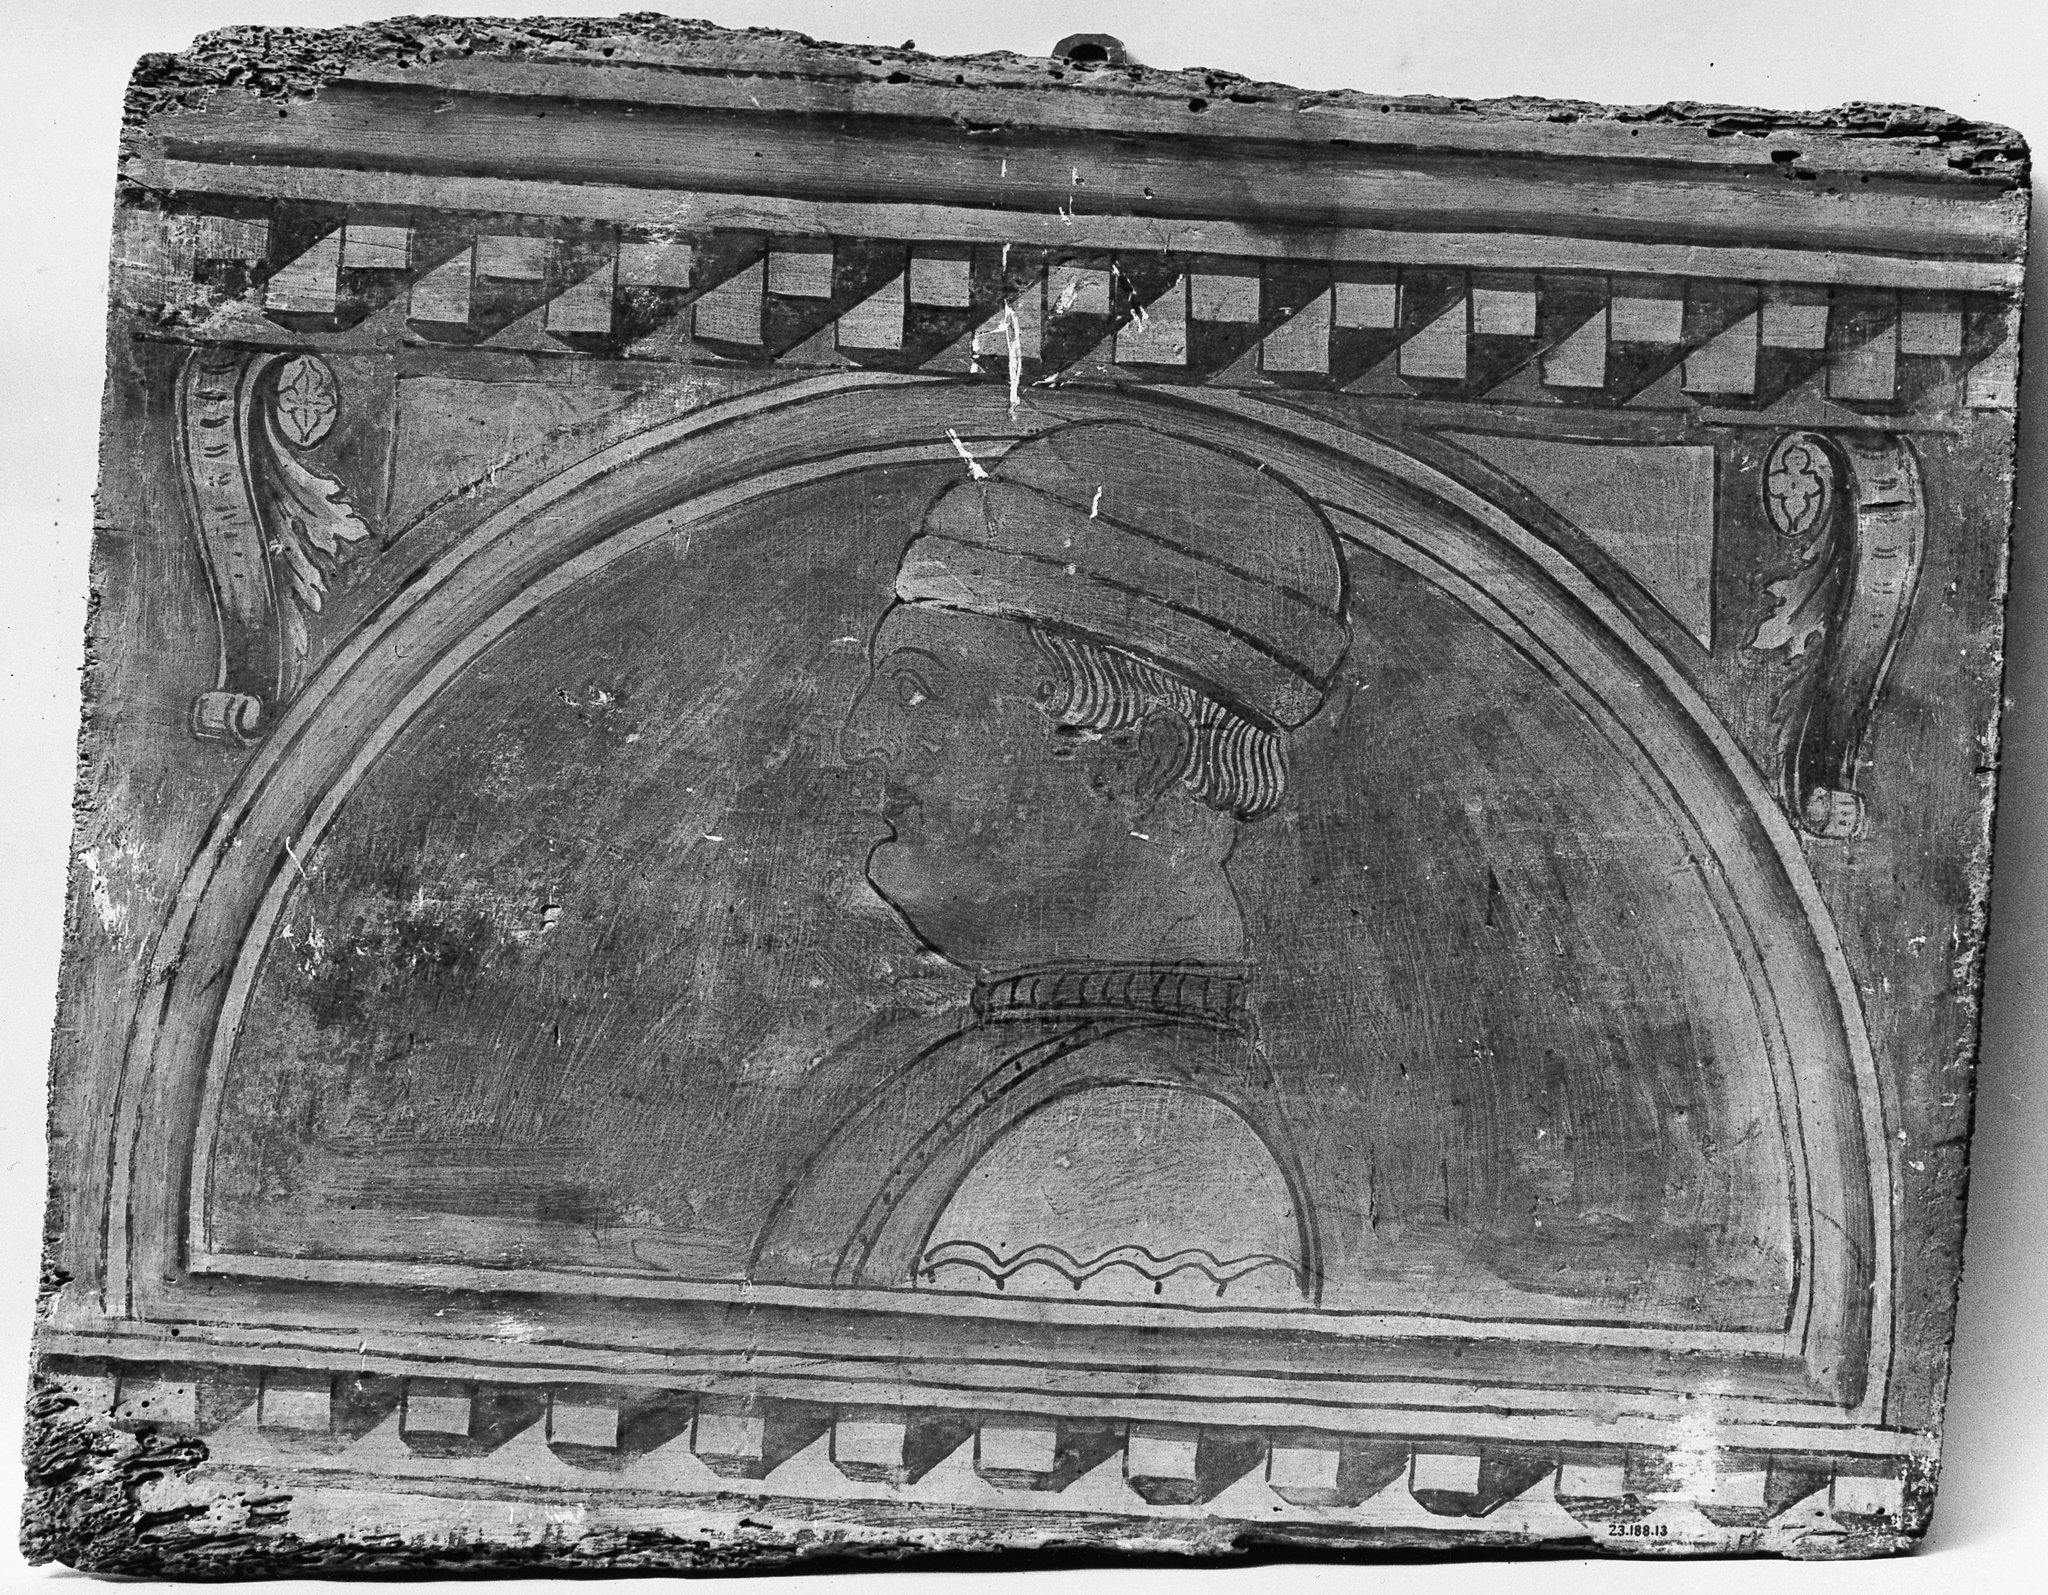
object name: frieze panel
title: Head of a man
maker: north italian painter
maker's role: artist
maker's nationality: italian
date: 1467-1500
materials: paint, wood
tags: men,profiles